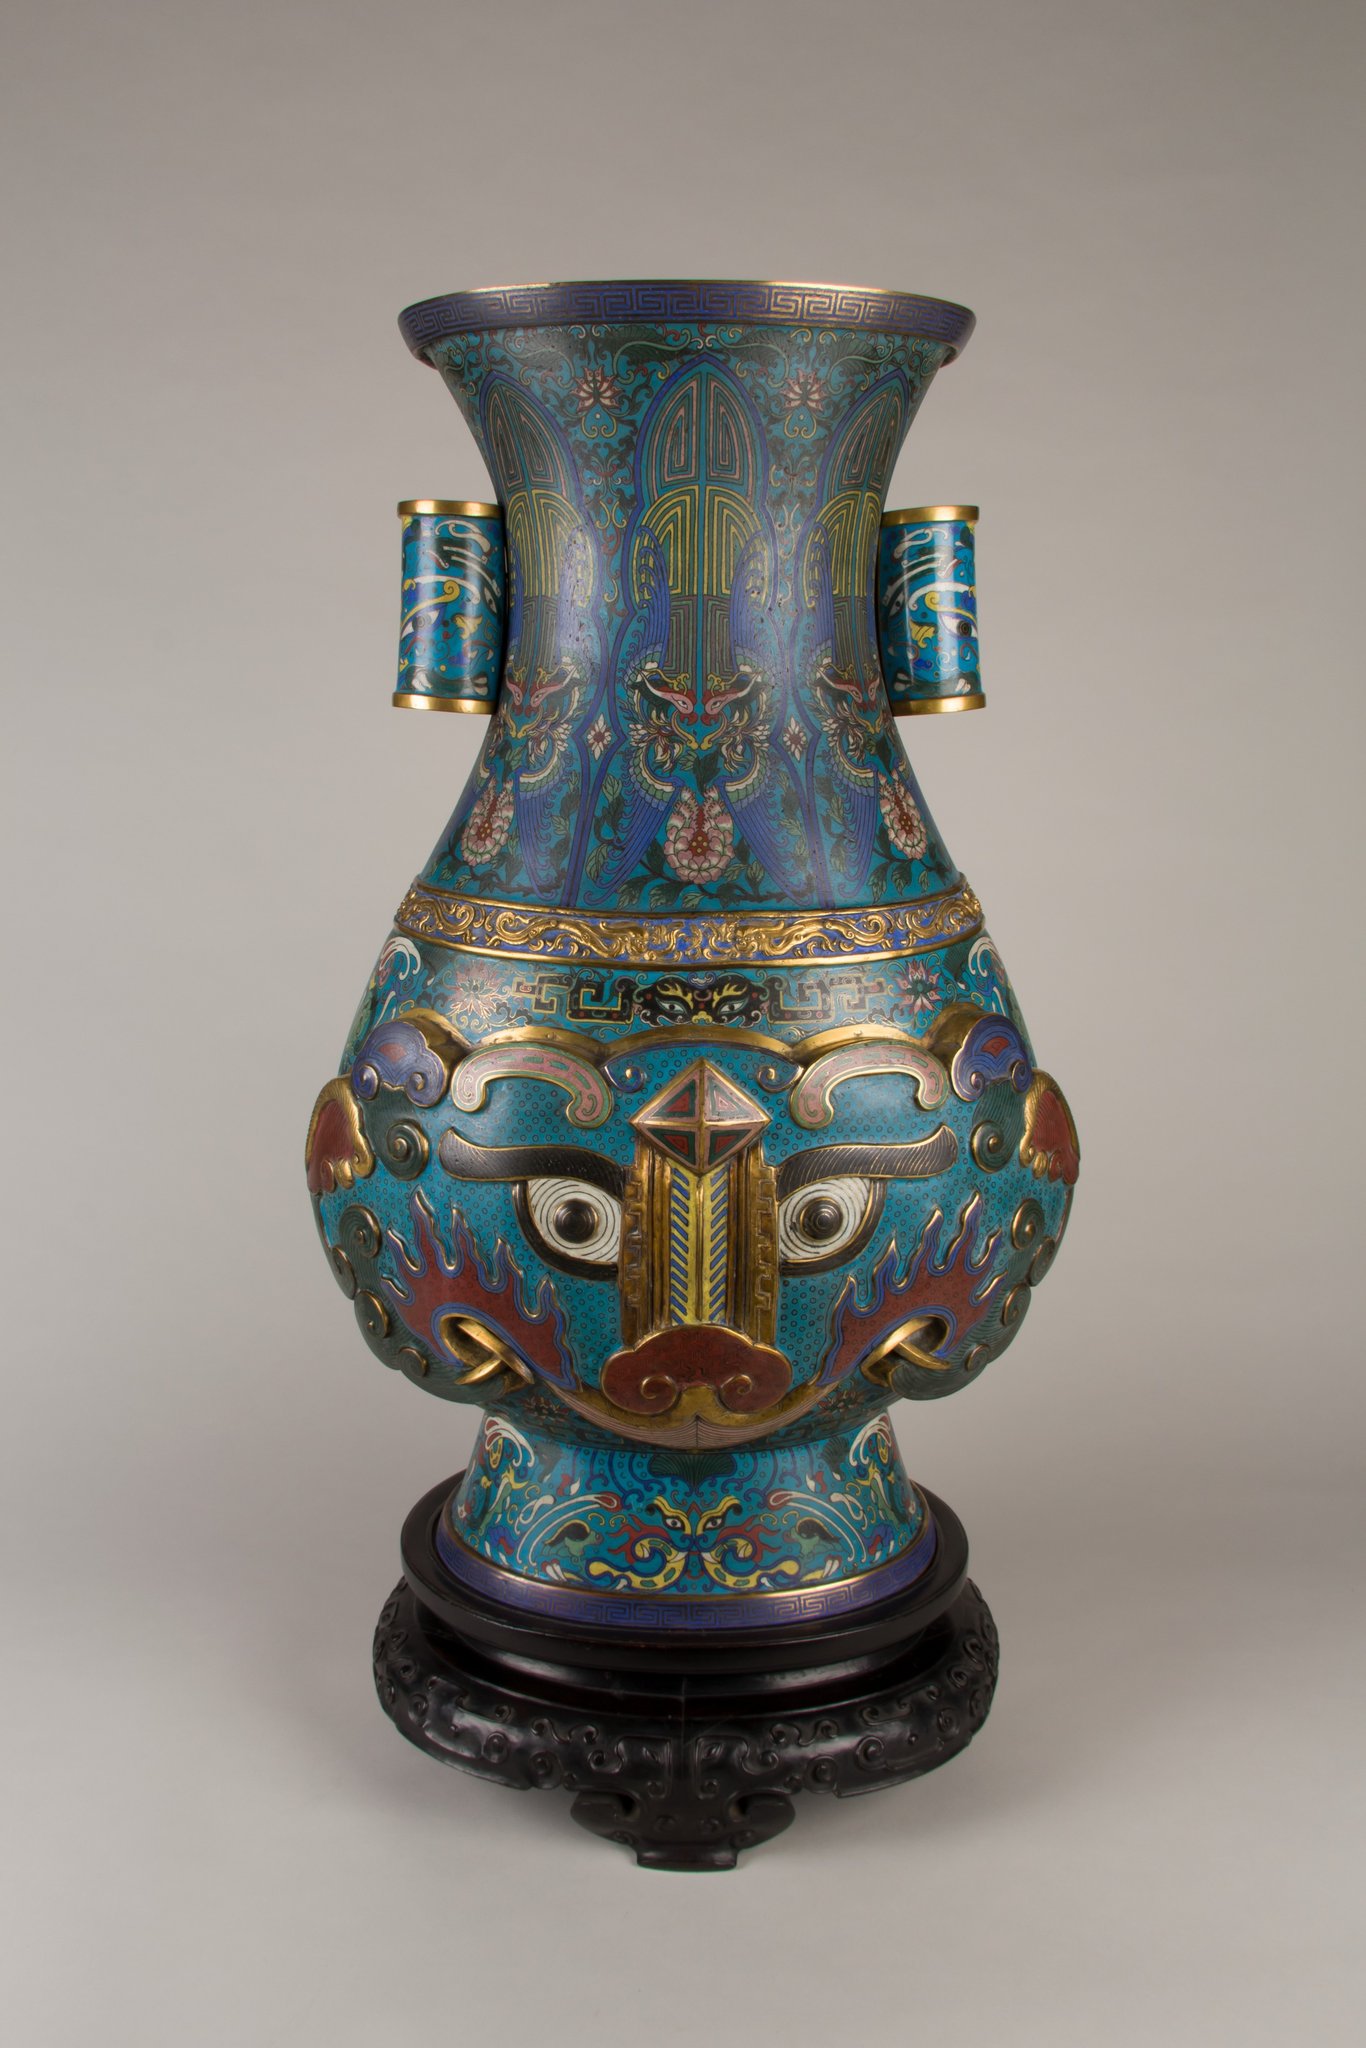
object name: vase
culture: chinese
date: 1801-1900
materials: enamel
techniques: enamel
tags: eyes